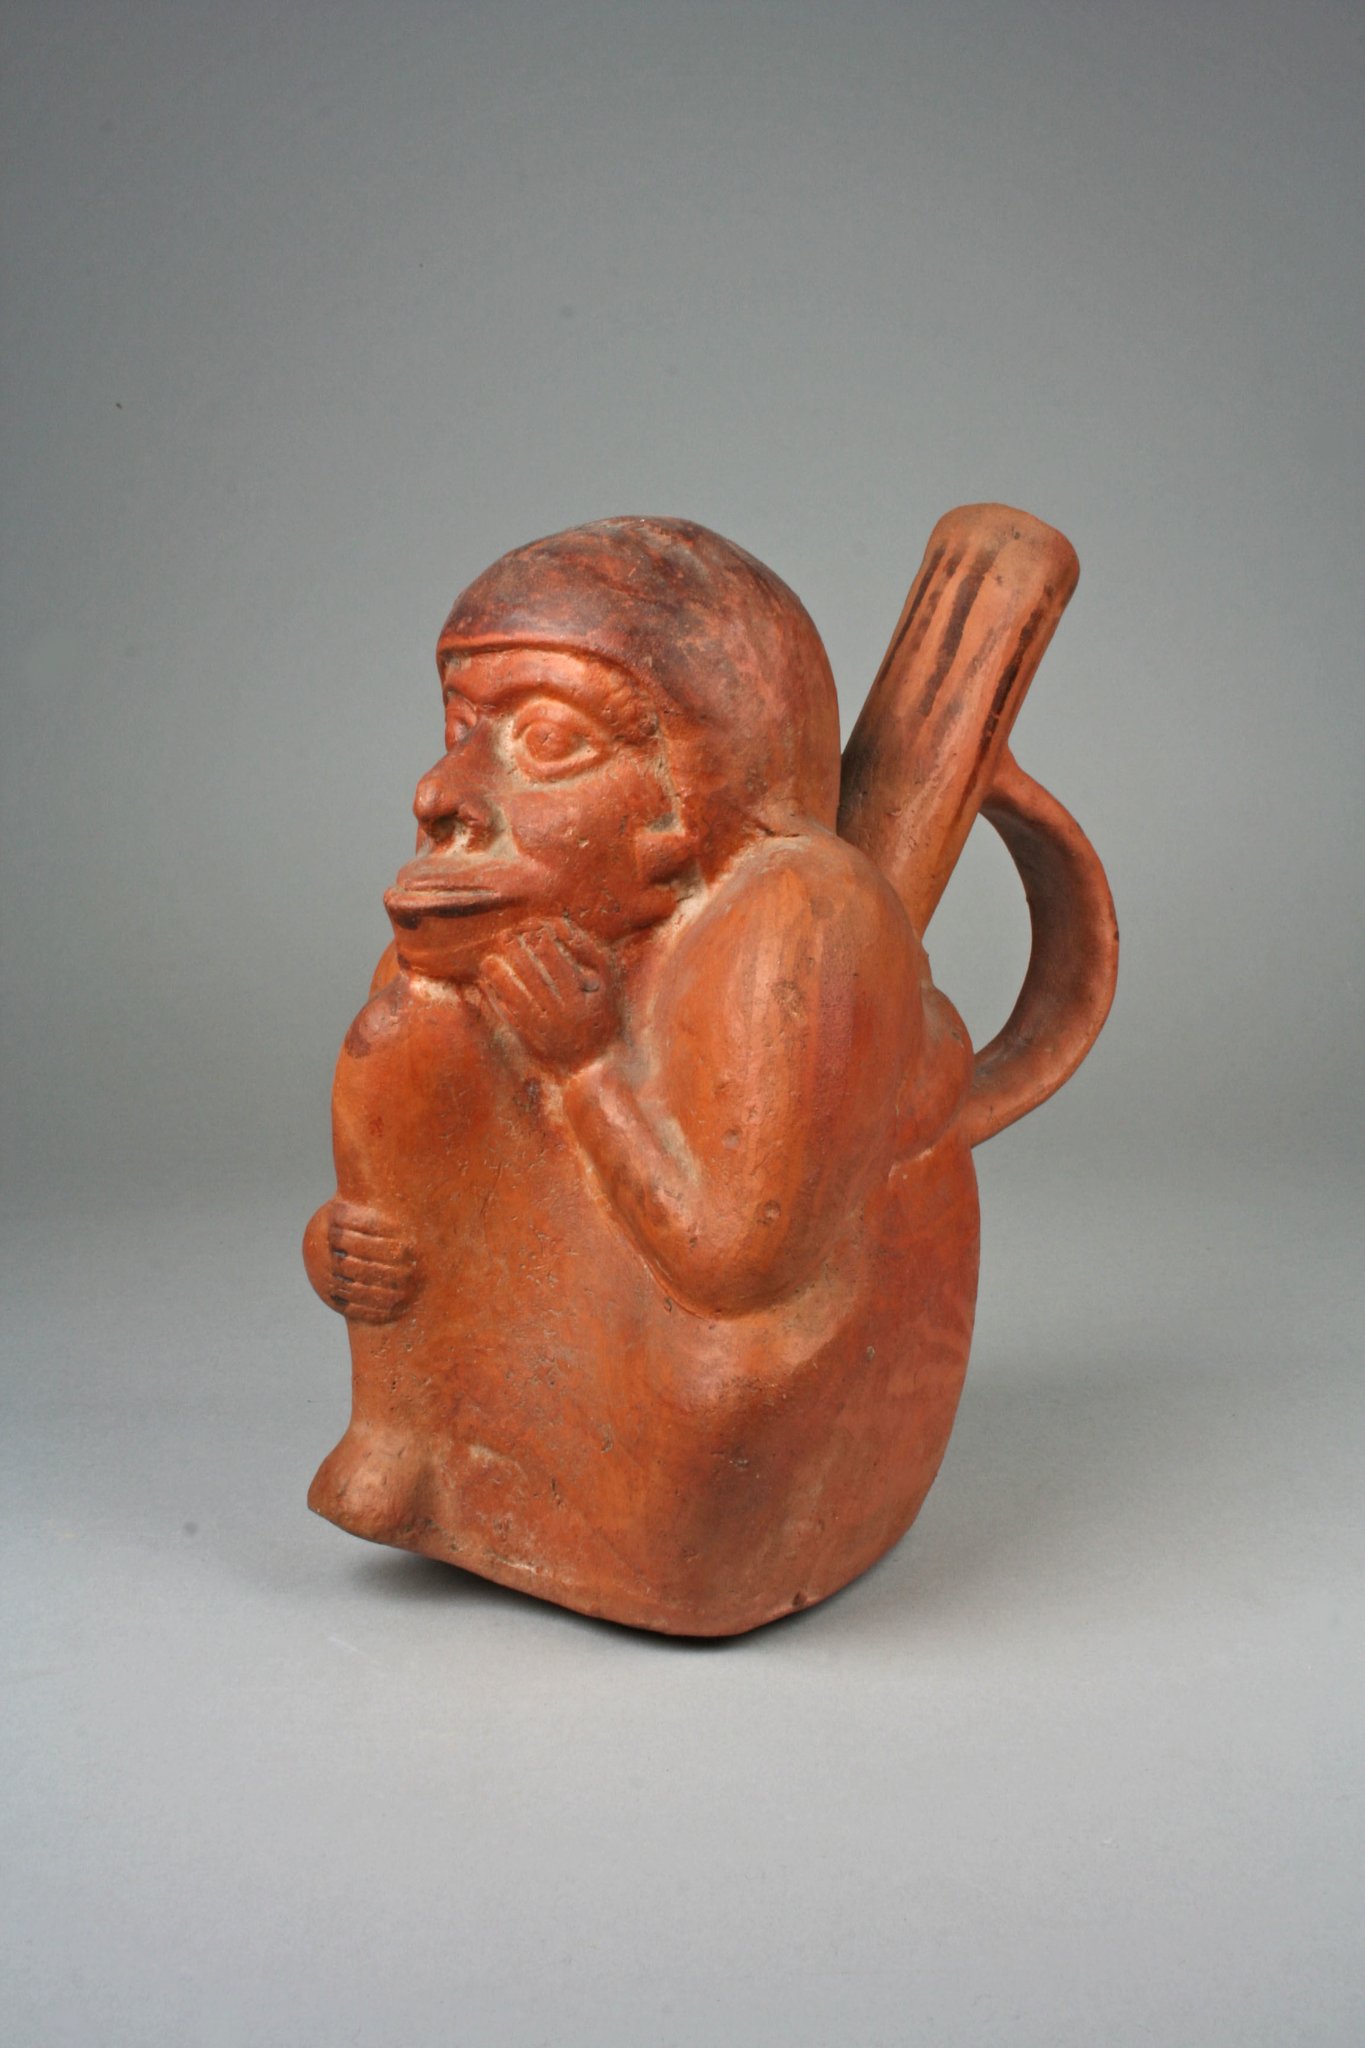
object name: bottle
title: Single Spout Monkey Figure Bottle with Strap Handle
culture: moche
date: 501-700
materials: ceramic, pigment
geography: peru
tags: monkeys